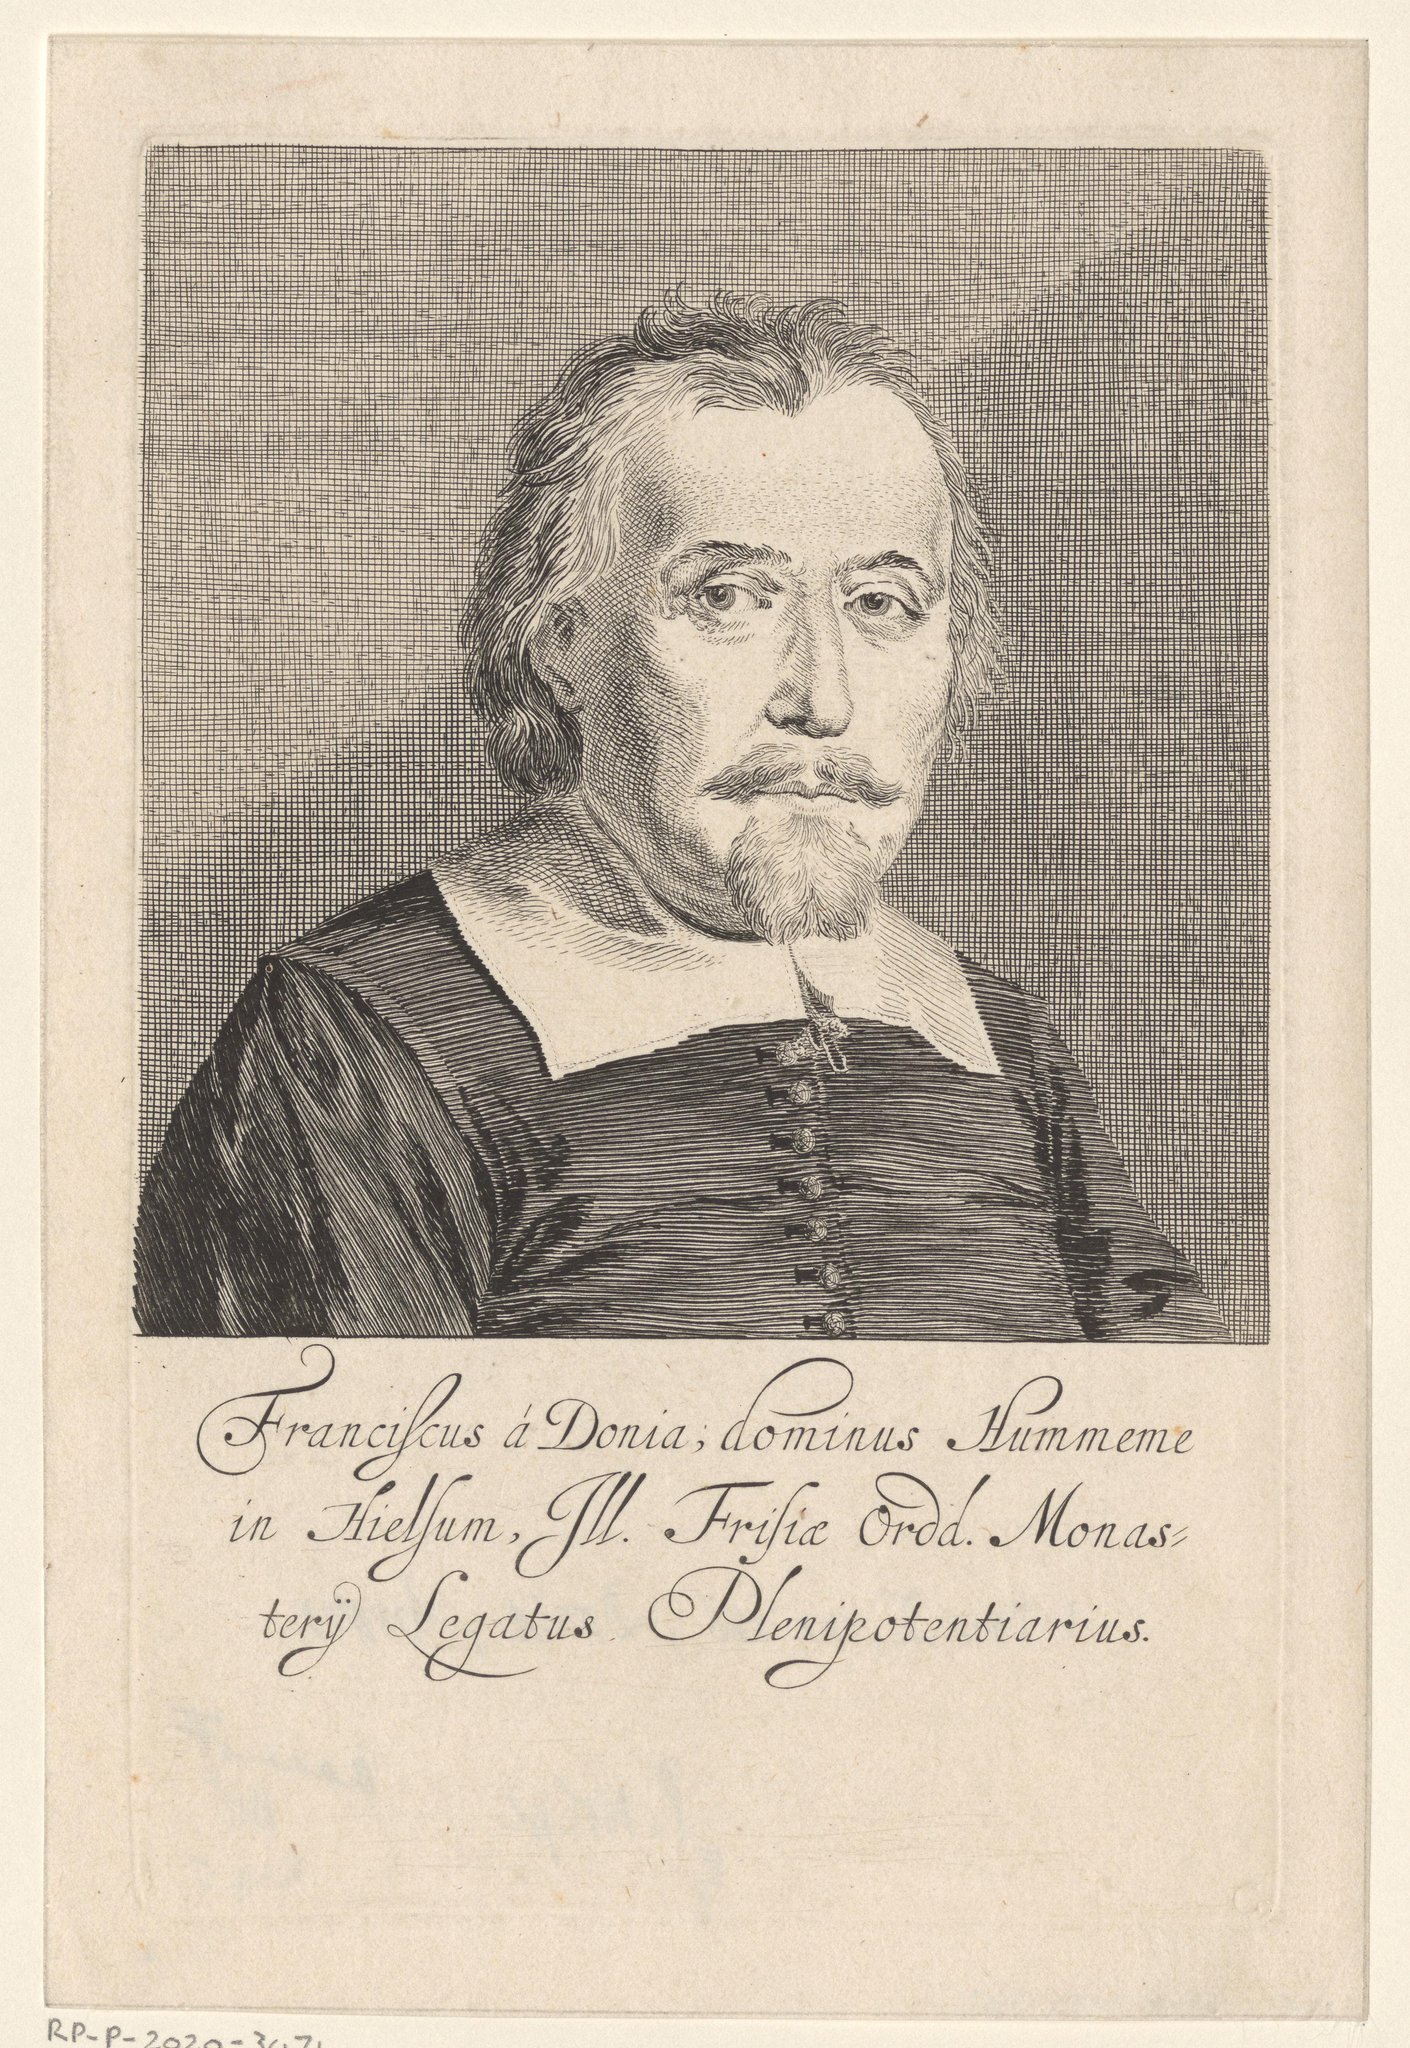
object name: print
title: Icones legatorum Monasterii et Osnabrugae existentium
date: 1644-1646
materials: paper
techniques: engraving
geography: amsterdam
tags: the hague, commander-in-chief, general, marshal, historical persons, diplomacy, diplomat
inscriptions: collector's mark: Lugt 789a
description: Prent maakt deel uit van een serie van 43 prenten. Latere staat van prent gebruikt in de serie 'Pacificatores orbis Christiani in Westphaliam missi anno 1641', uitgegeven door Rombout van den Hoeye in Amsterdam.